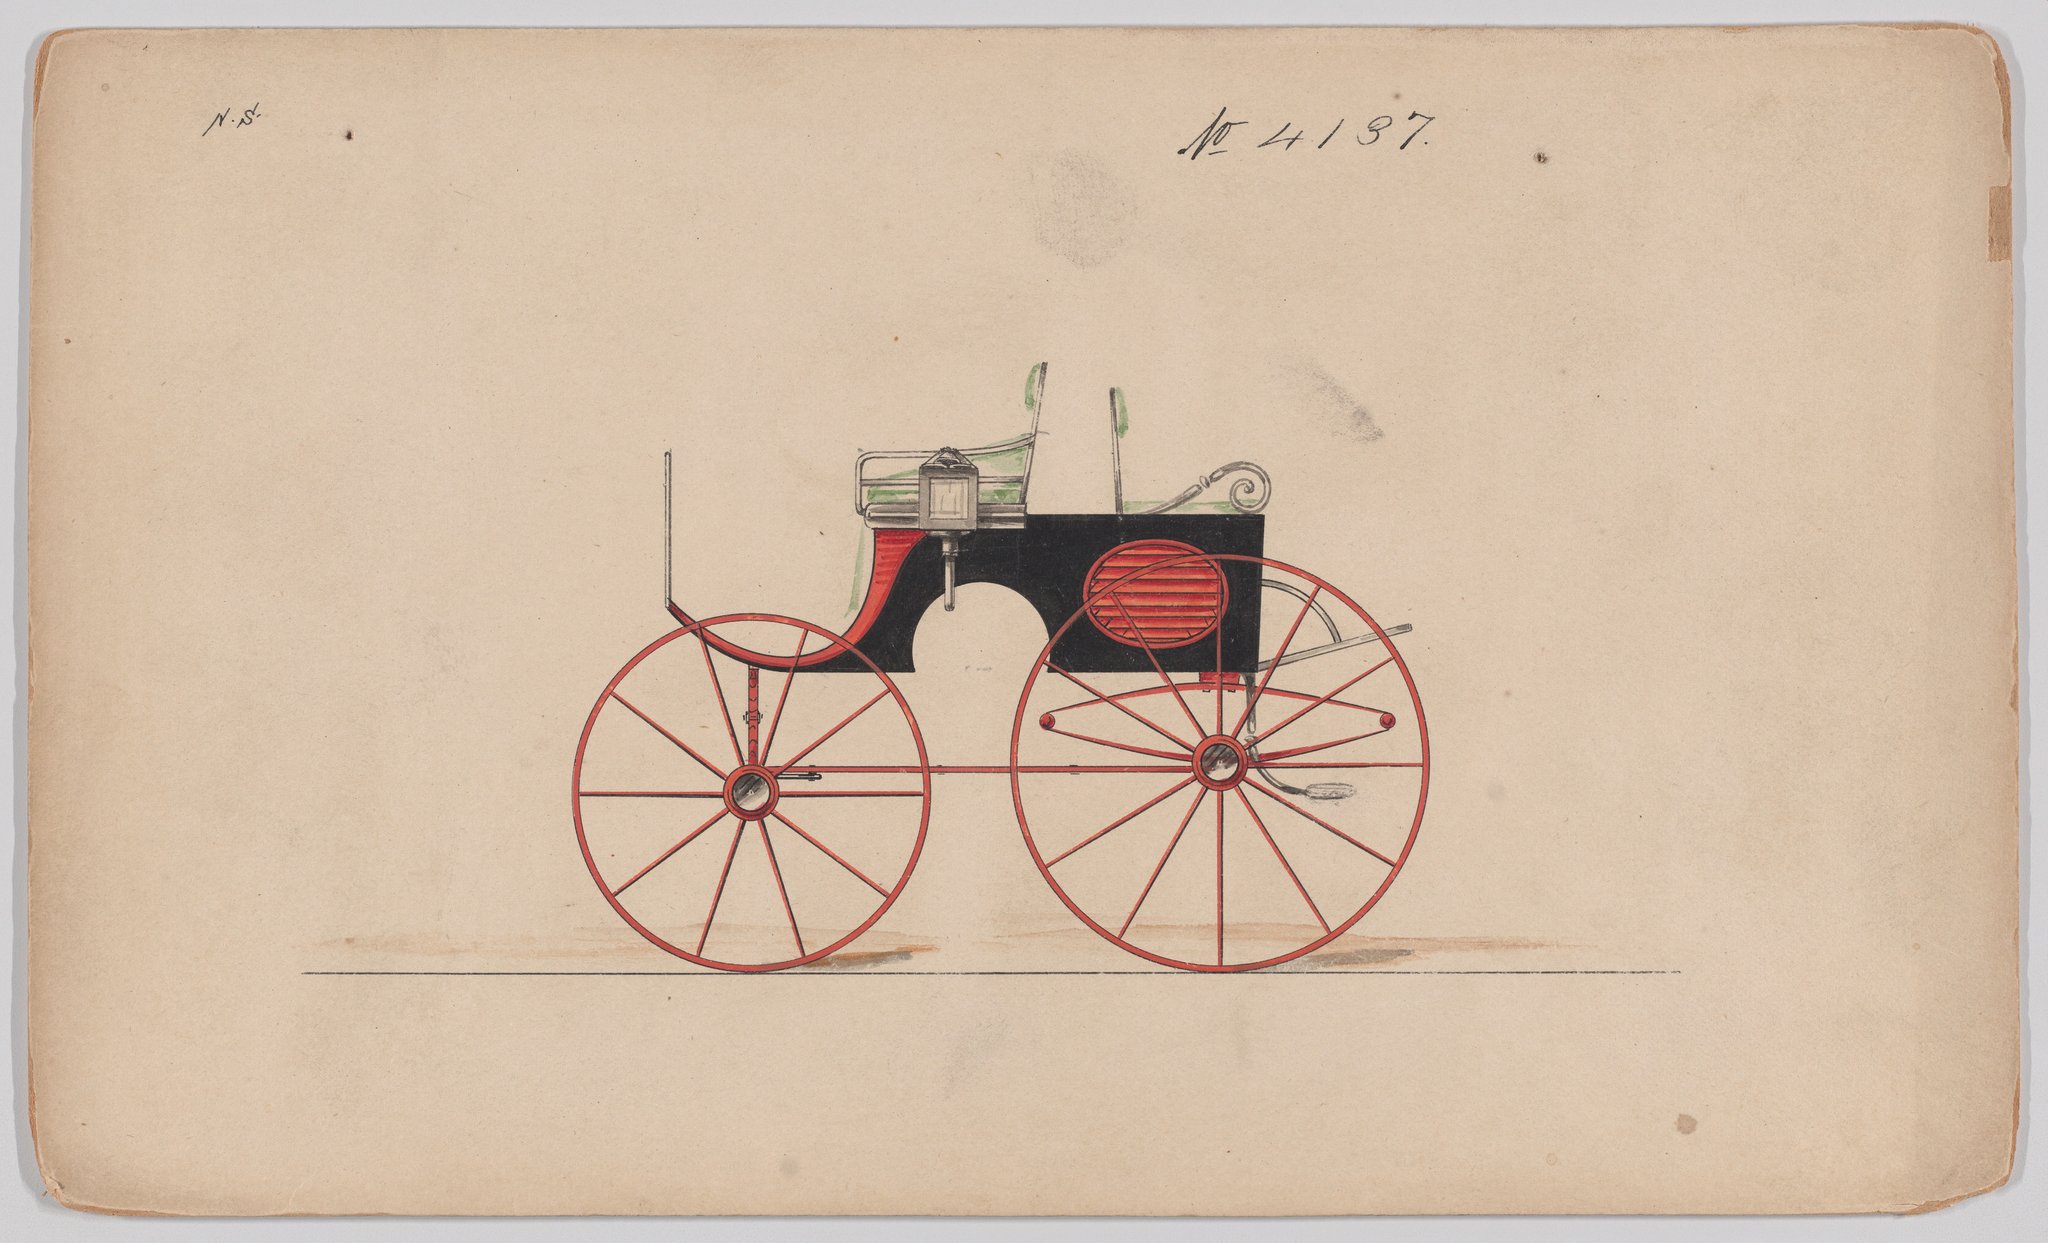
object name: drawing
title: Design for Dog Cart or 2 Wheeler, no. 4137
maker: brewster & co.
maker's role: manufacturer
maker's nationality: american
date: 1891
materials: gouache, ink, watercolor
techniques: pen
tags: carriages